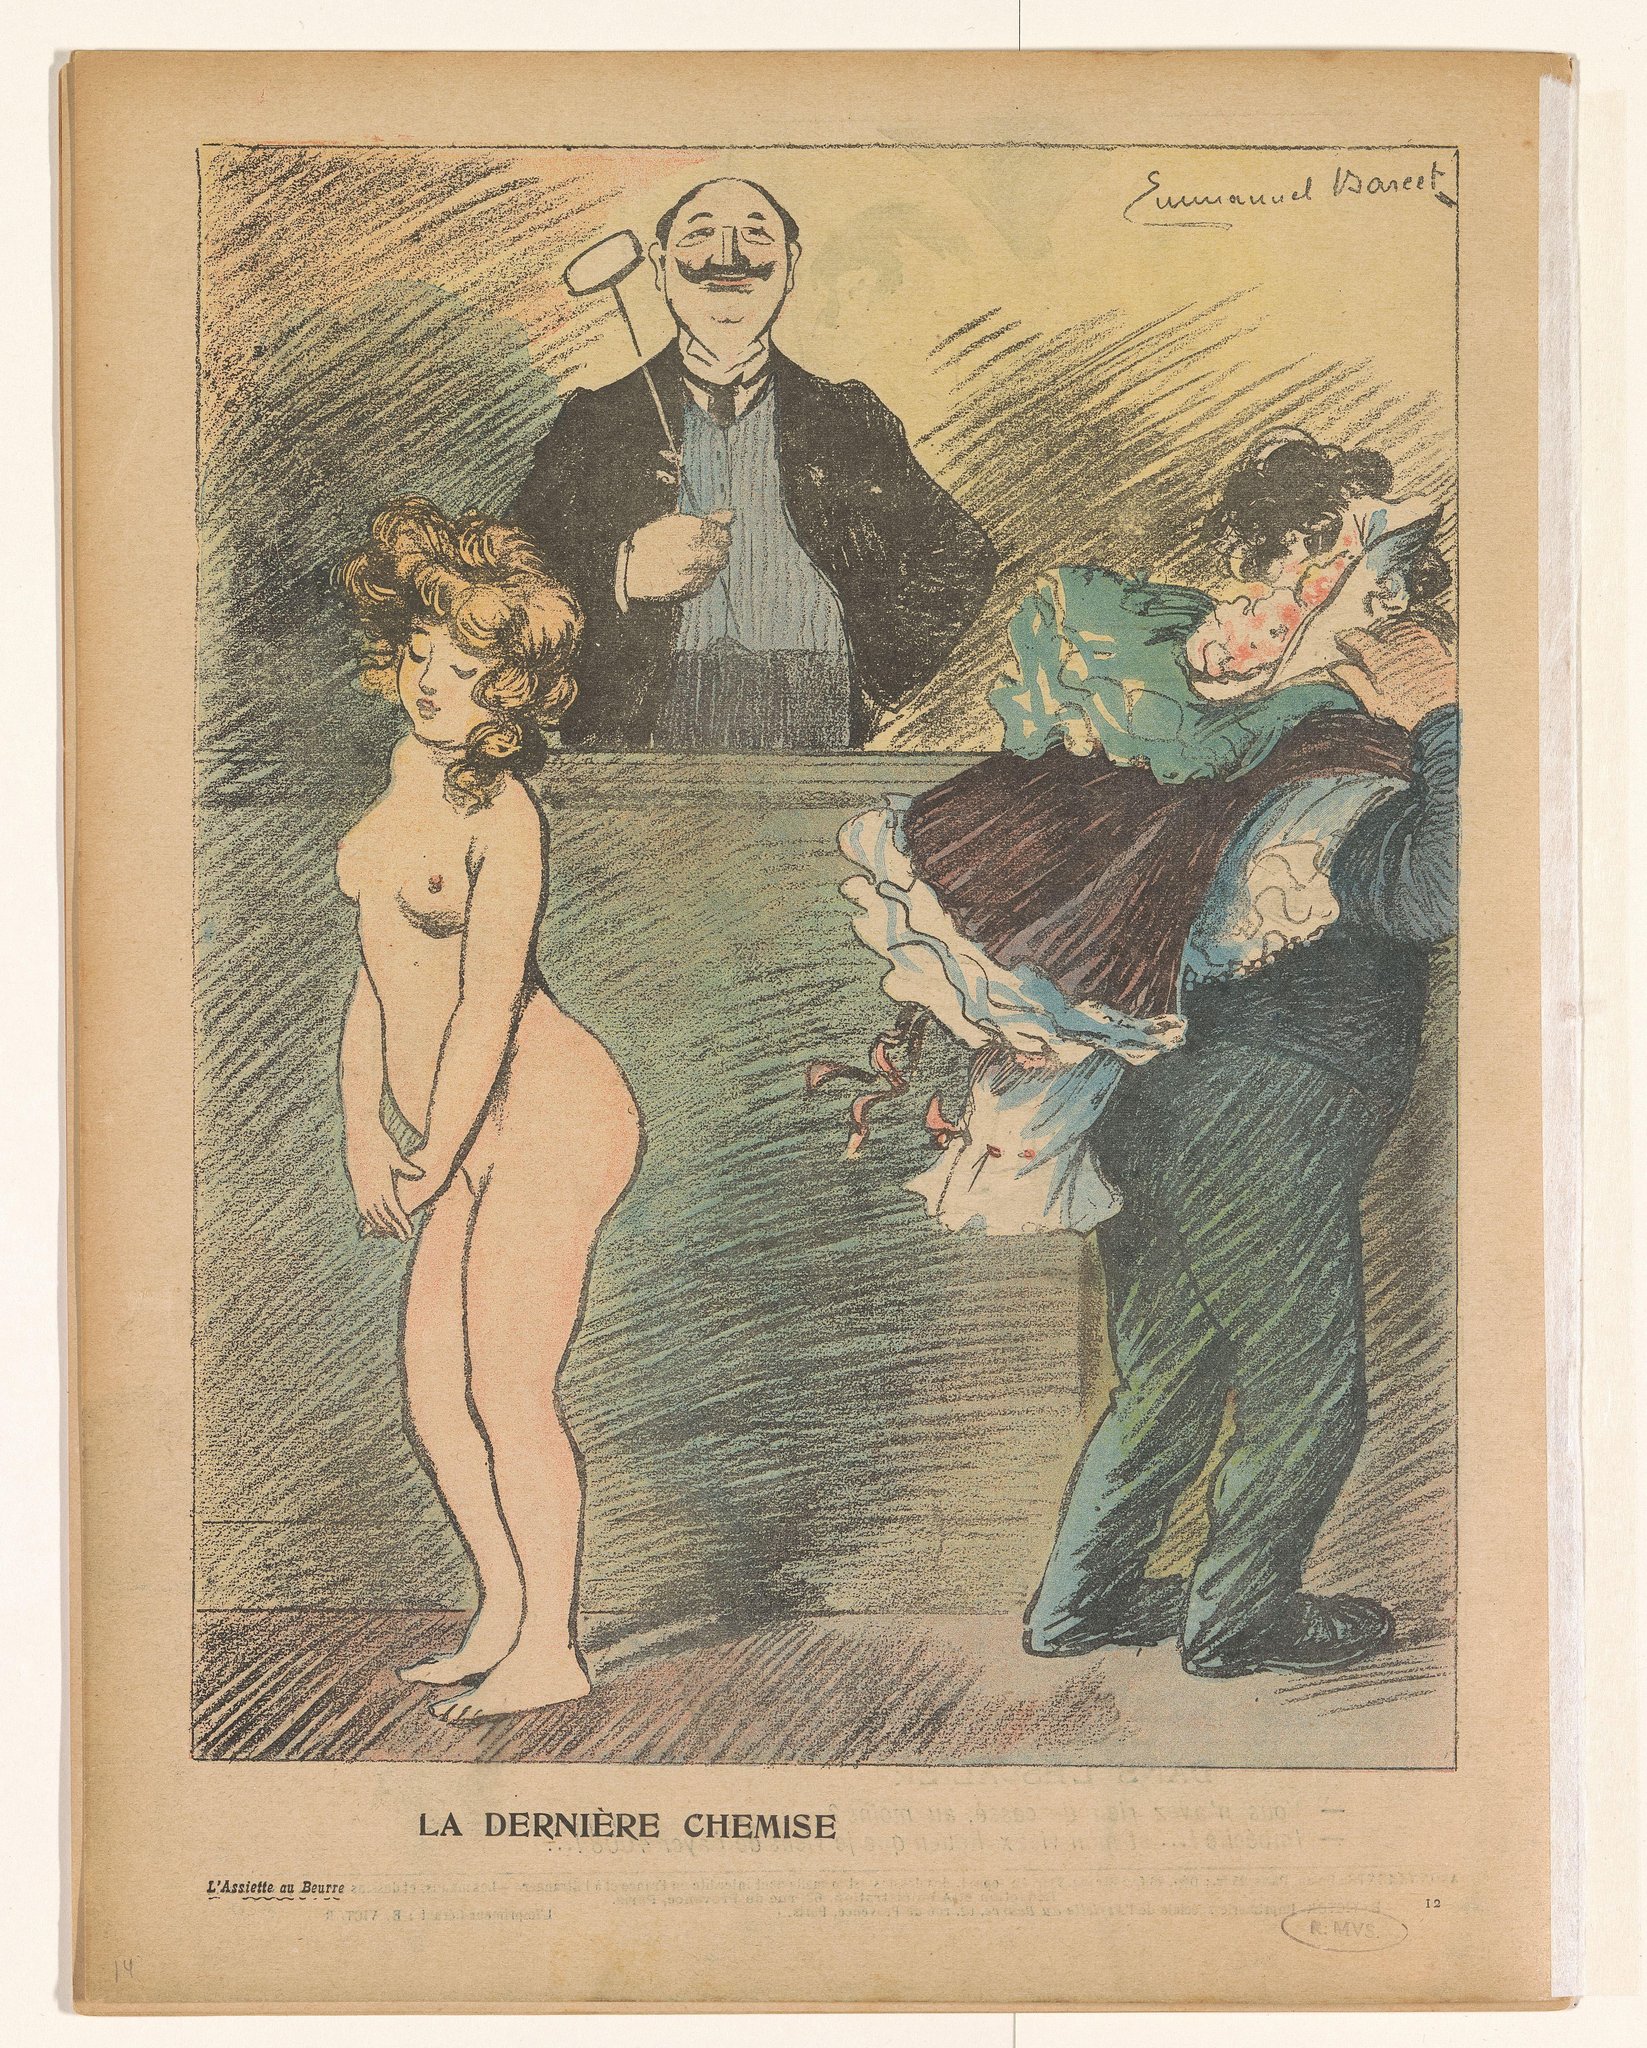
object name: magazine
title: La dernière chemise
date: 1905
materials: paper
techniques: lithograph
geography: paris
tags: caricatures (human types), the (nude) human figure; 'corpo humano' (ripa) - aa - female human figure, art sale, auction, political caricatures and satires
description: Op een verhoging staat een veilinghouder met een hamer in zijn rechterhand. Voor hem op de grond staat een naakte vrouw. Haar jurk wordt weggedragen door een man. De prent verwijst naar de dubbele betekenis van het woord 'chemise' dat zowel jurk als map kan betekenen. De prent maakt onderdeel uit van een tijdschrift.